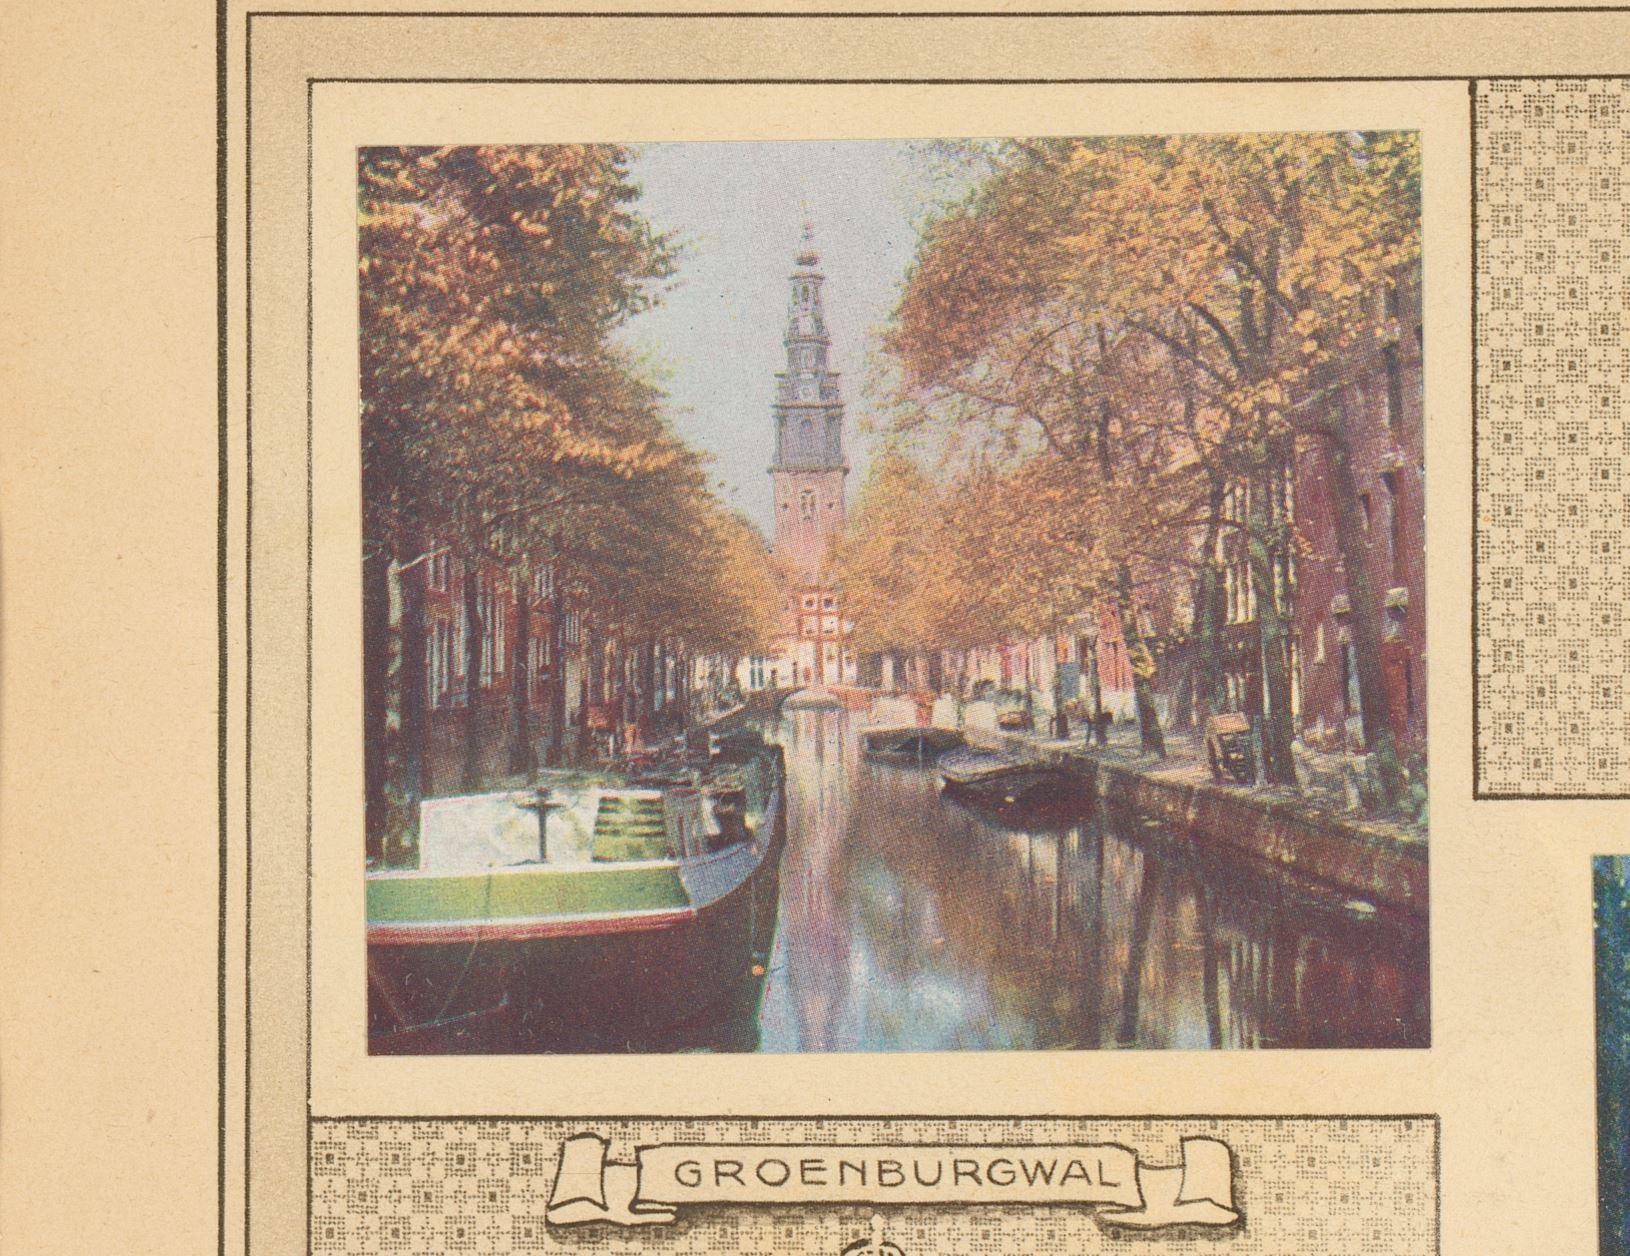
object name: photomechanical print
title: Gezicht op de Groenburgwal in Amsterdam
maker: Anonymous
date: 1915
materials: paper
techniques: rotogravure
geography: amsterdam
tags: canals, waters (in city)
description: Deze prent maakt deel uit van een album.